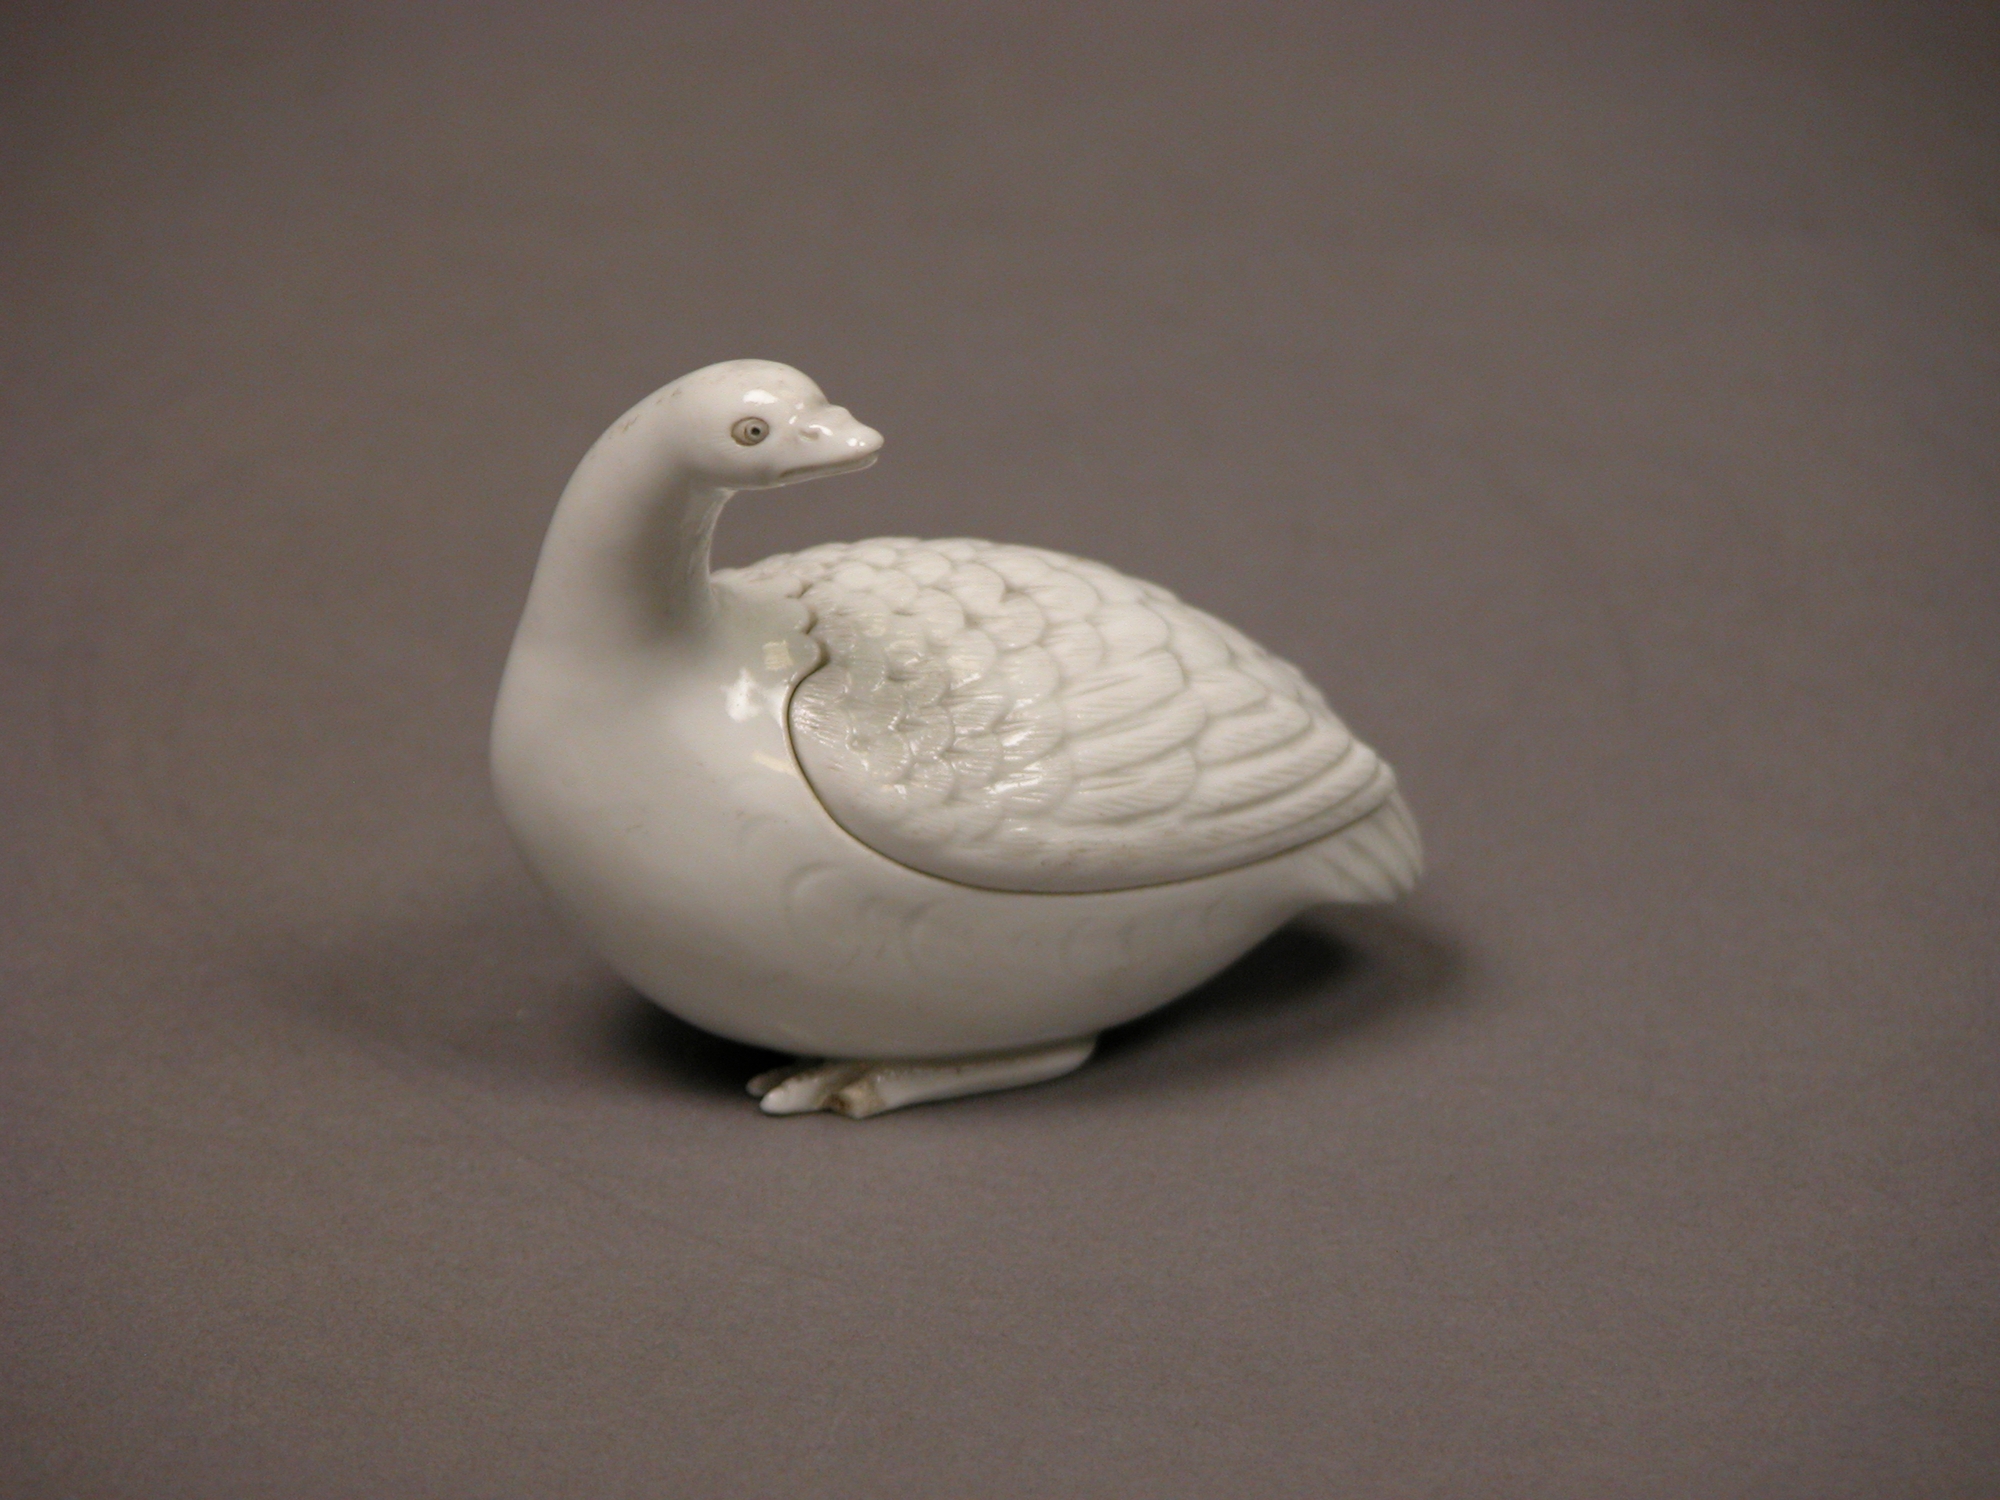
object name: water holder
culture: japanese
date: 1820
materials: porcelain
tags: ducks